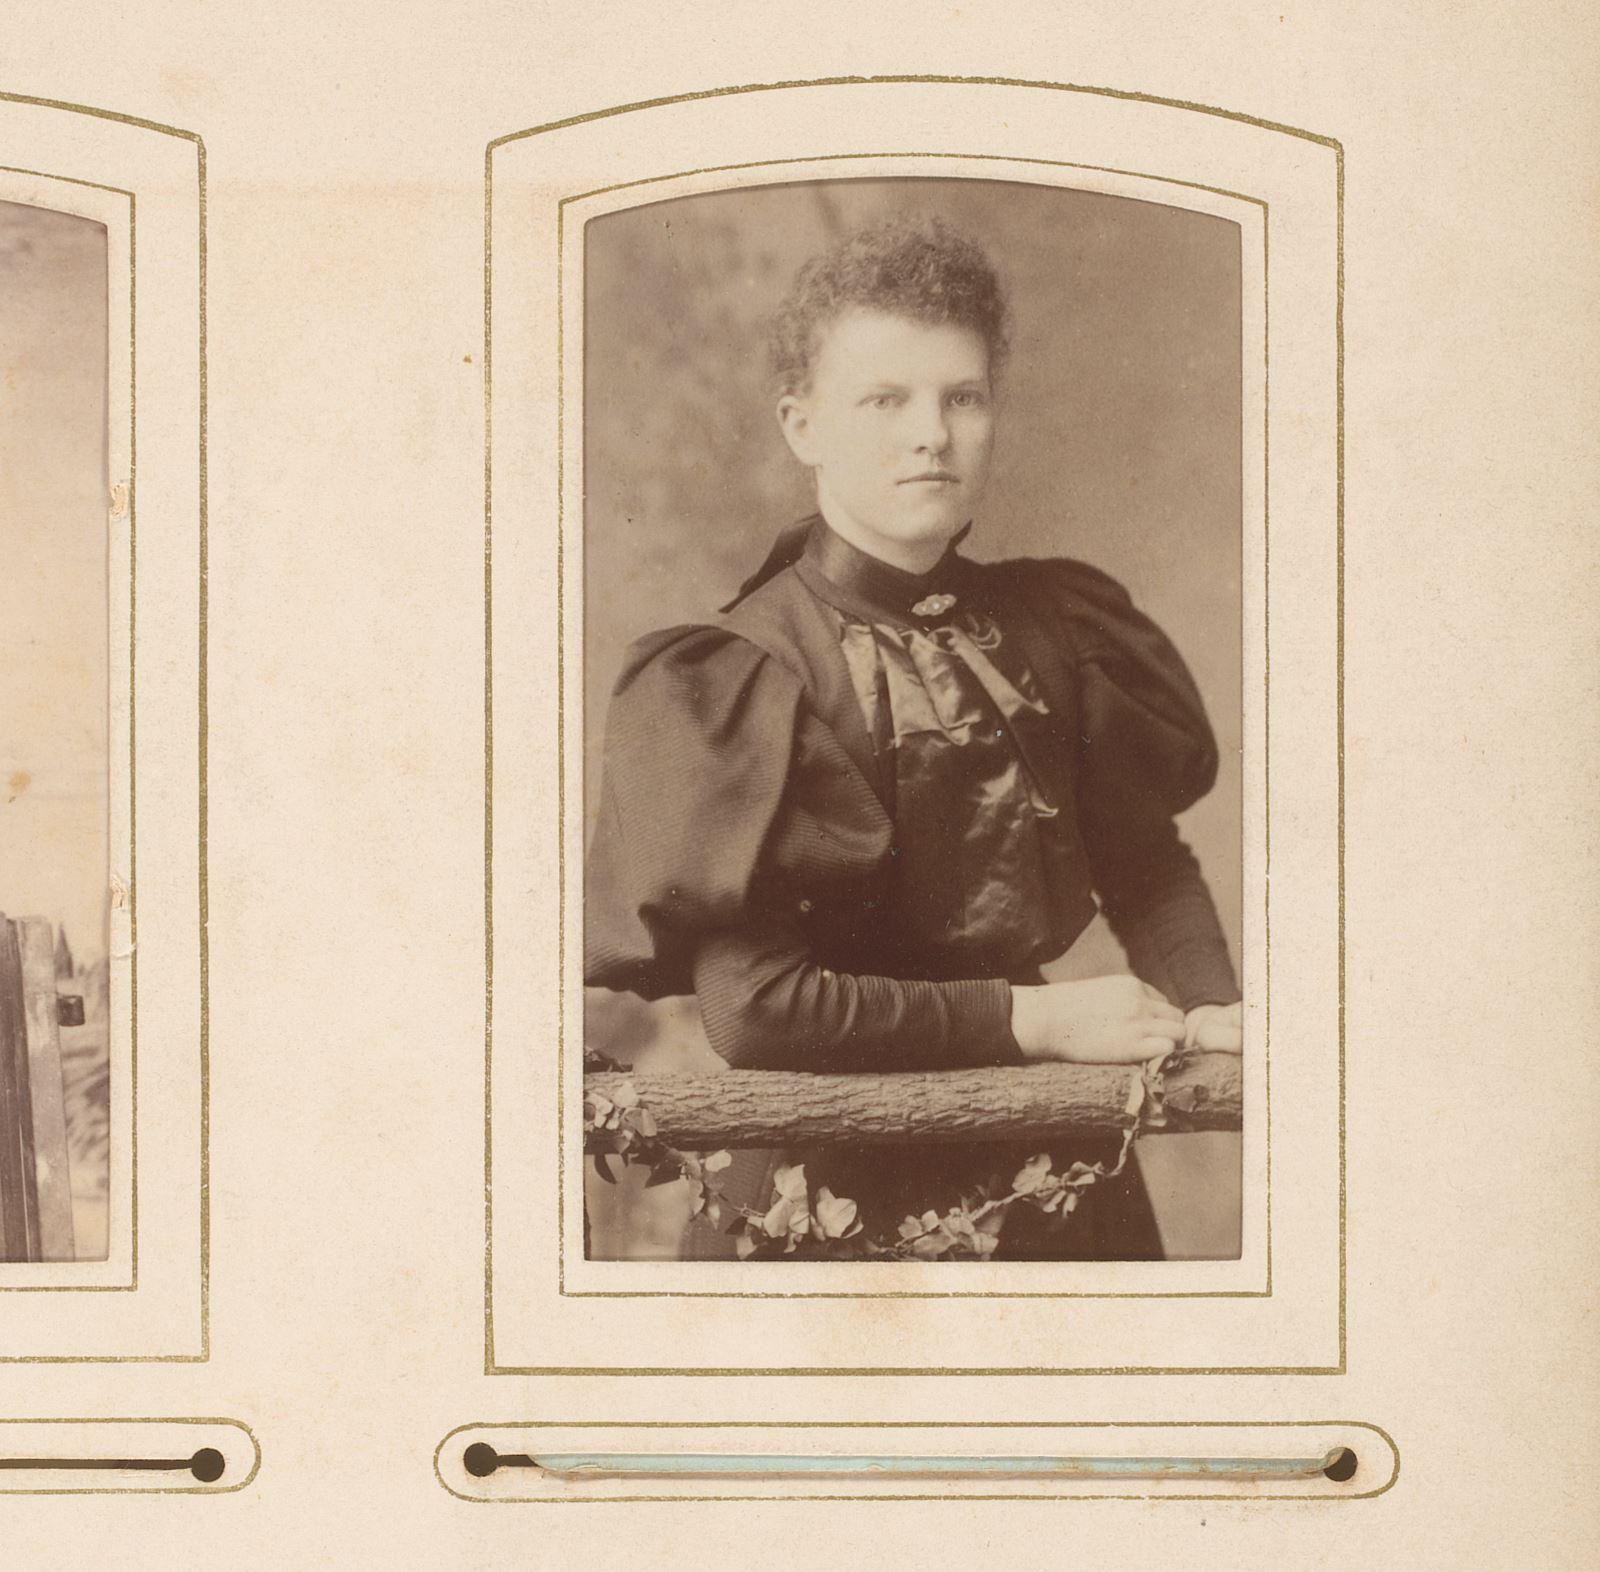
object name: carte de visite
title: Portret van een vrouw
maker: a.t. osbourne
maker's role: fotograaf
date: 1860-1900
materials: cardboard, photographic support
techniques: albumen print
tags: adult woman, historical persons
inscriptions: inscription: ‘(...) A. T. Osbourne/ Hull/ Hessle Road/ 100 & 102 (...)’